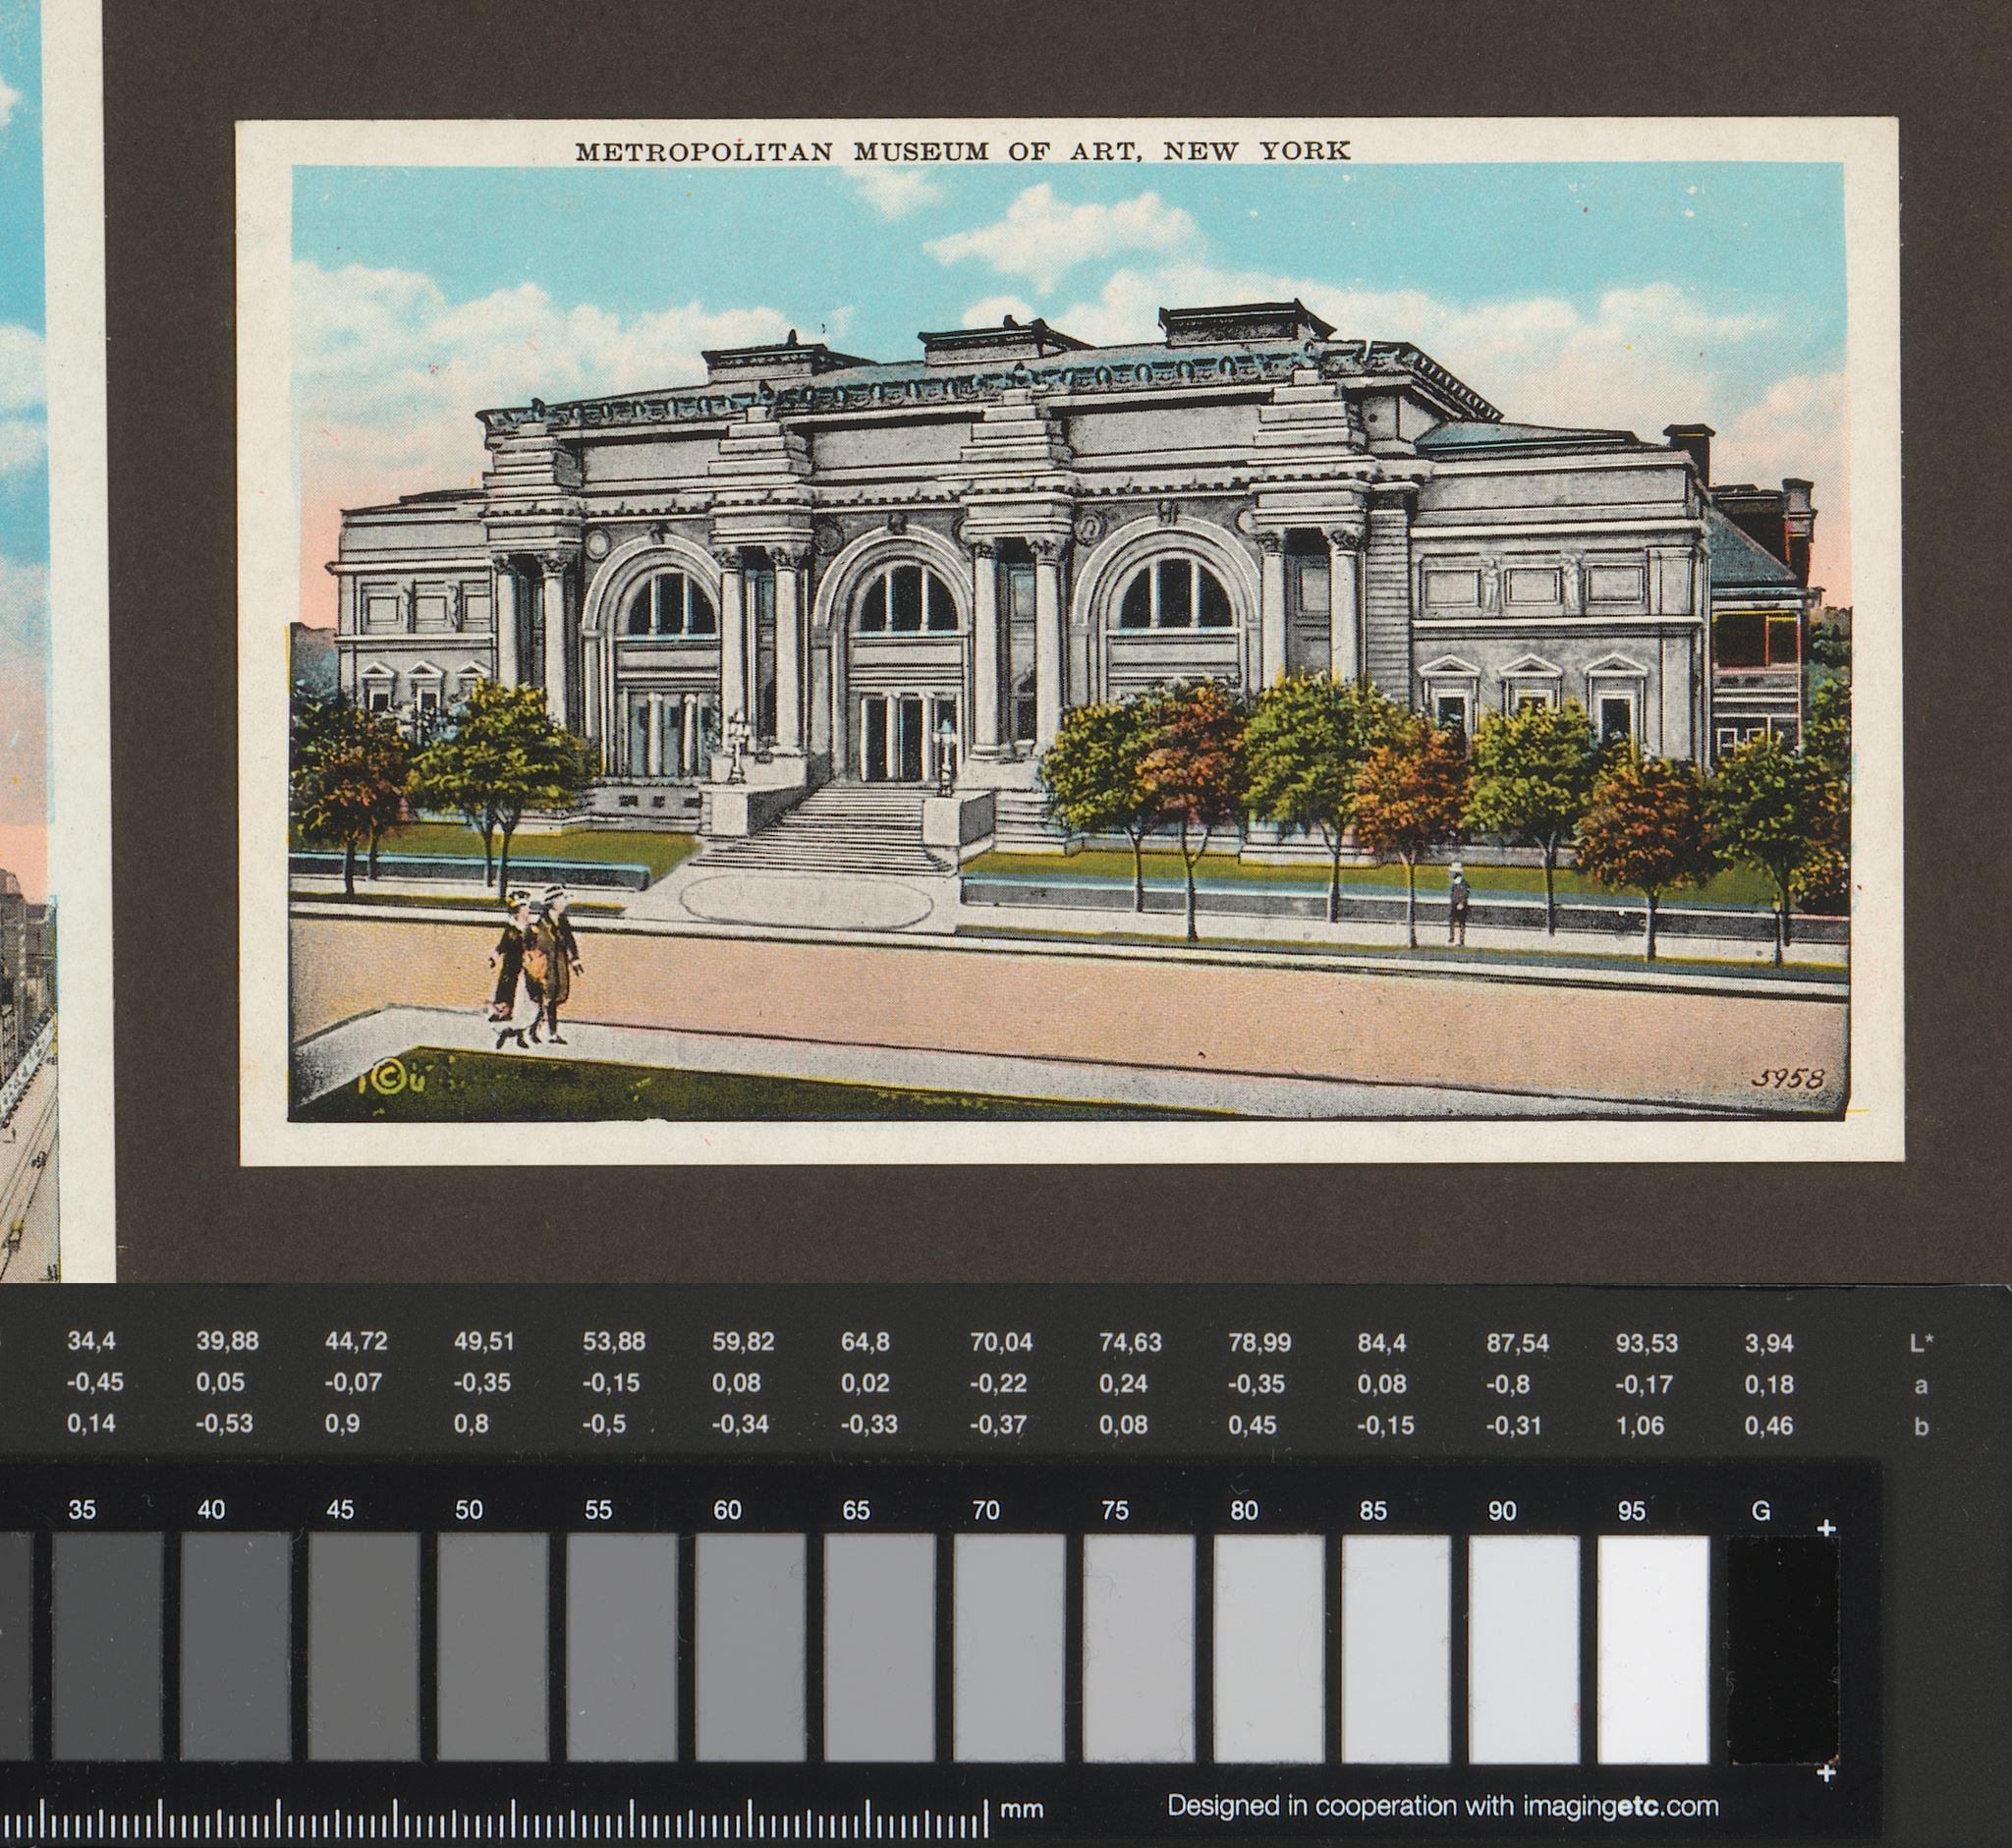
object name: album leaf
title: Metropolitan Museum of Art, New York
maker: Anonymous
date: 1928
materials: paper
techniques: four-color autotype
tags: permanent exhibition, museum, new york (city)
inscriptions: inscription: ‘I © U’, number: ‘5958’